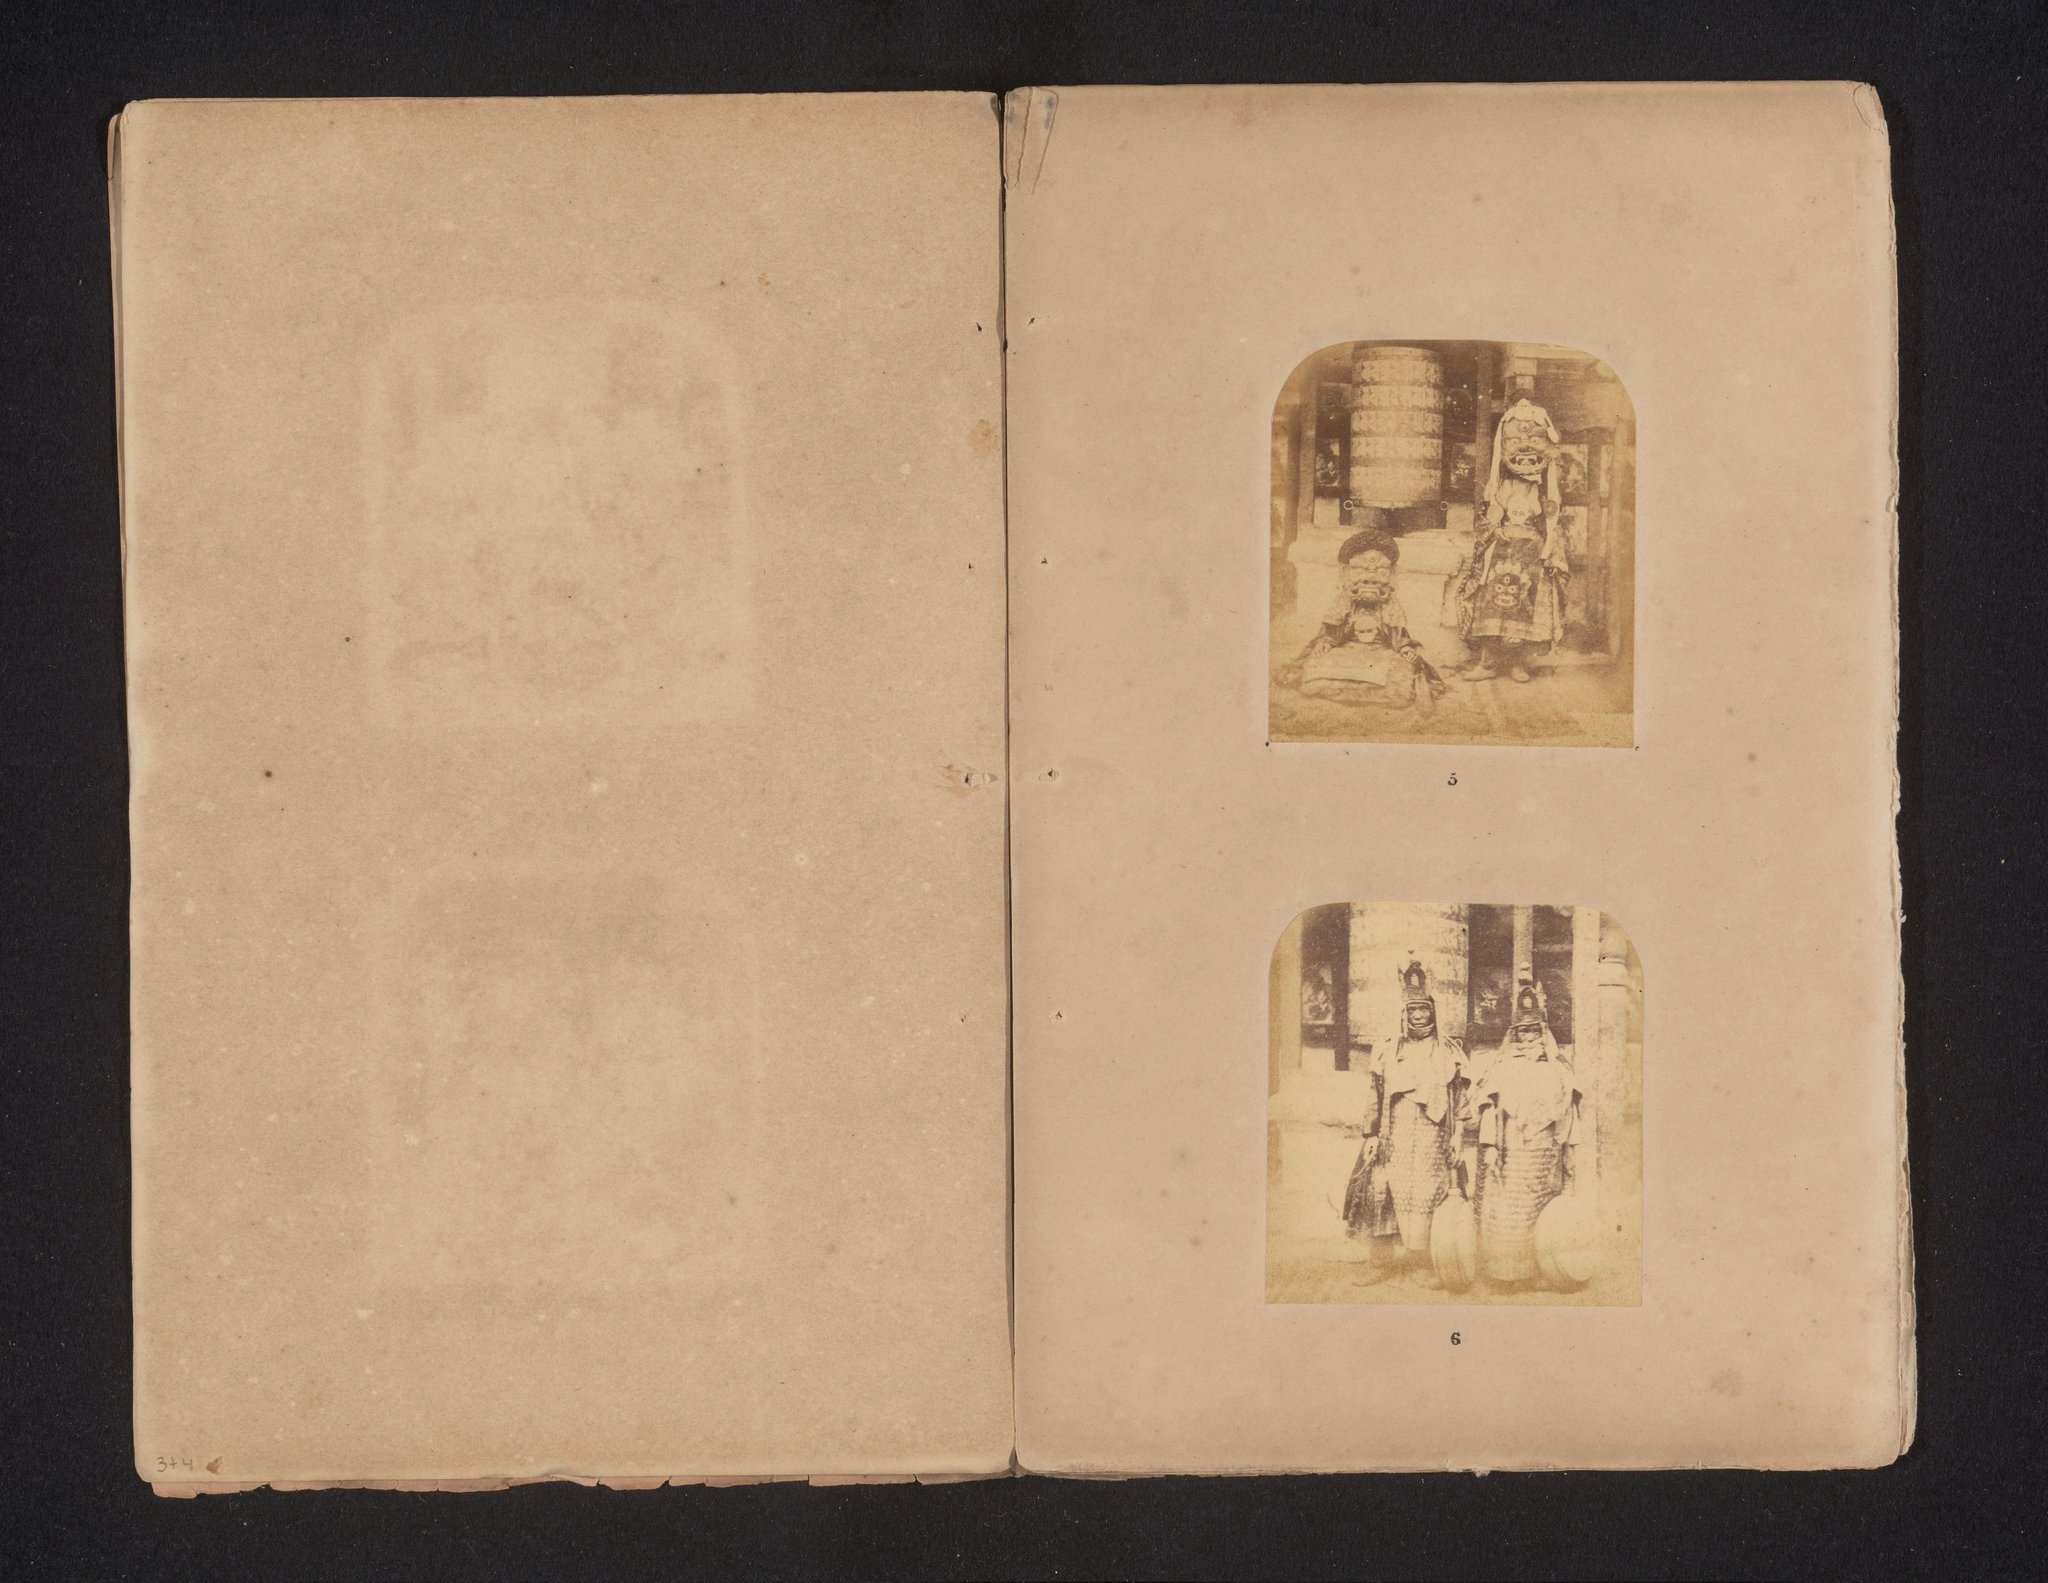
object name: page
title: Twee acteurs in kostuum uit een toneelstuk in India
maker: melville clark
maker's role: engineer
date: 1860-1865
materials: photographic support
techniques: albumen print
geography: india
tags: stage costume, portrait of actor, actress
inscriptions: number: ‘6’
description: Foto op vijfde ongenummerde pagina na pagina 74. Foto is de helft van een stereofoto.